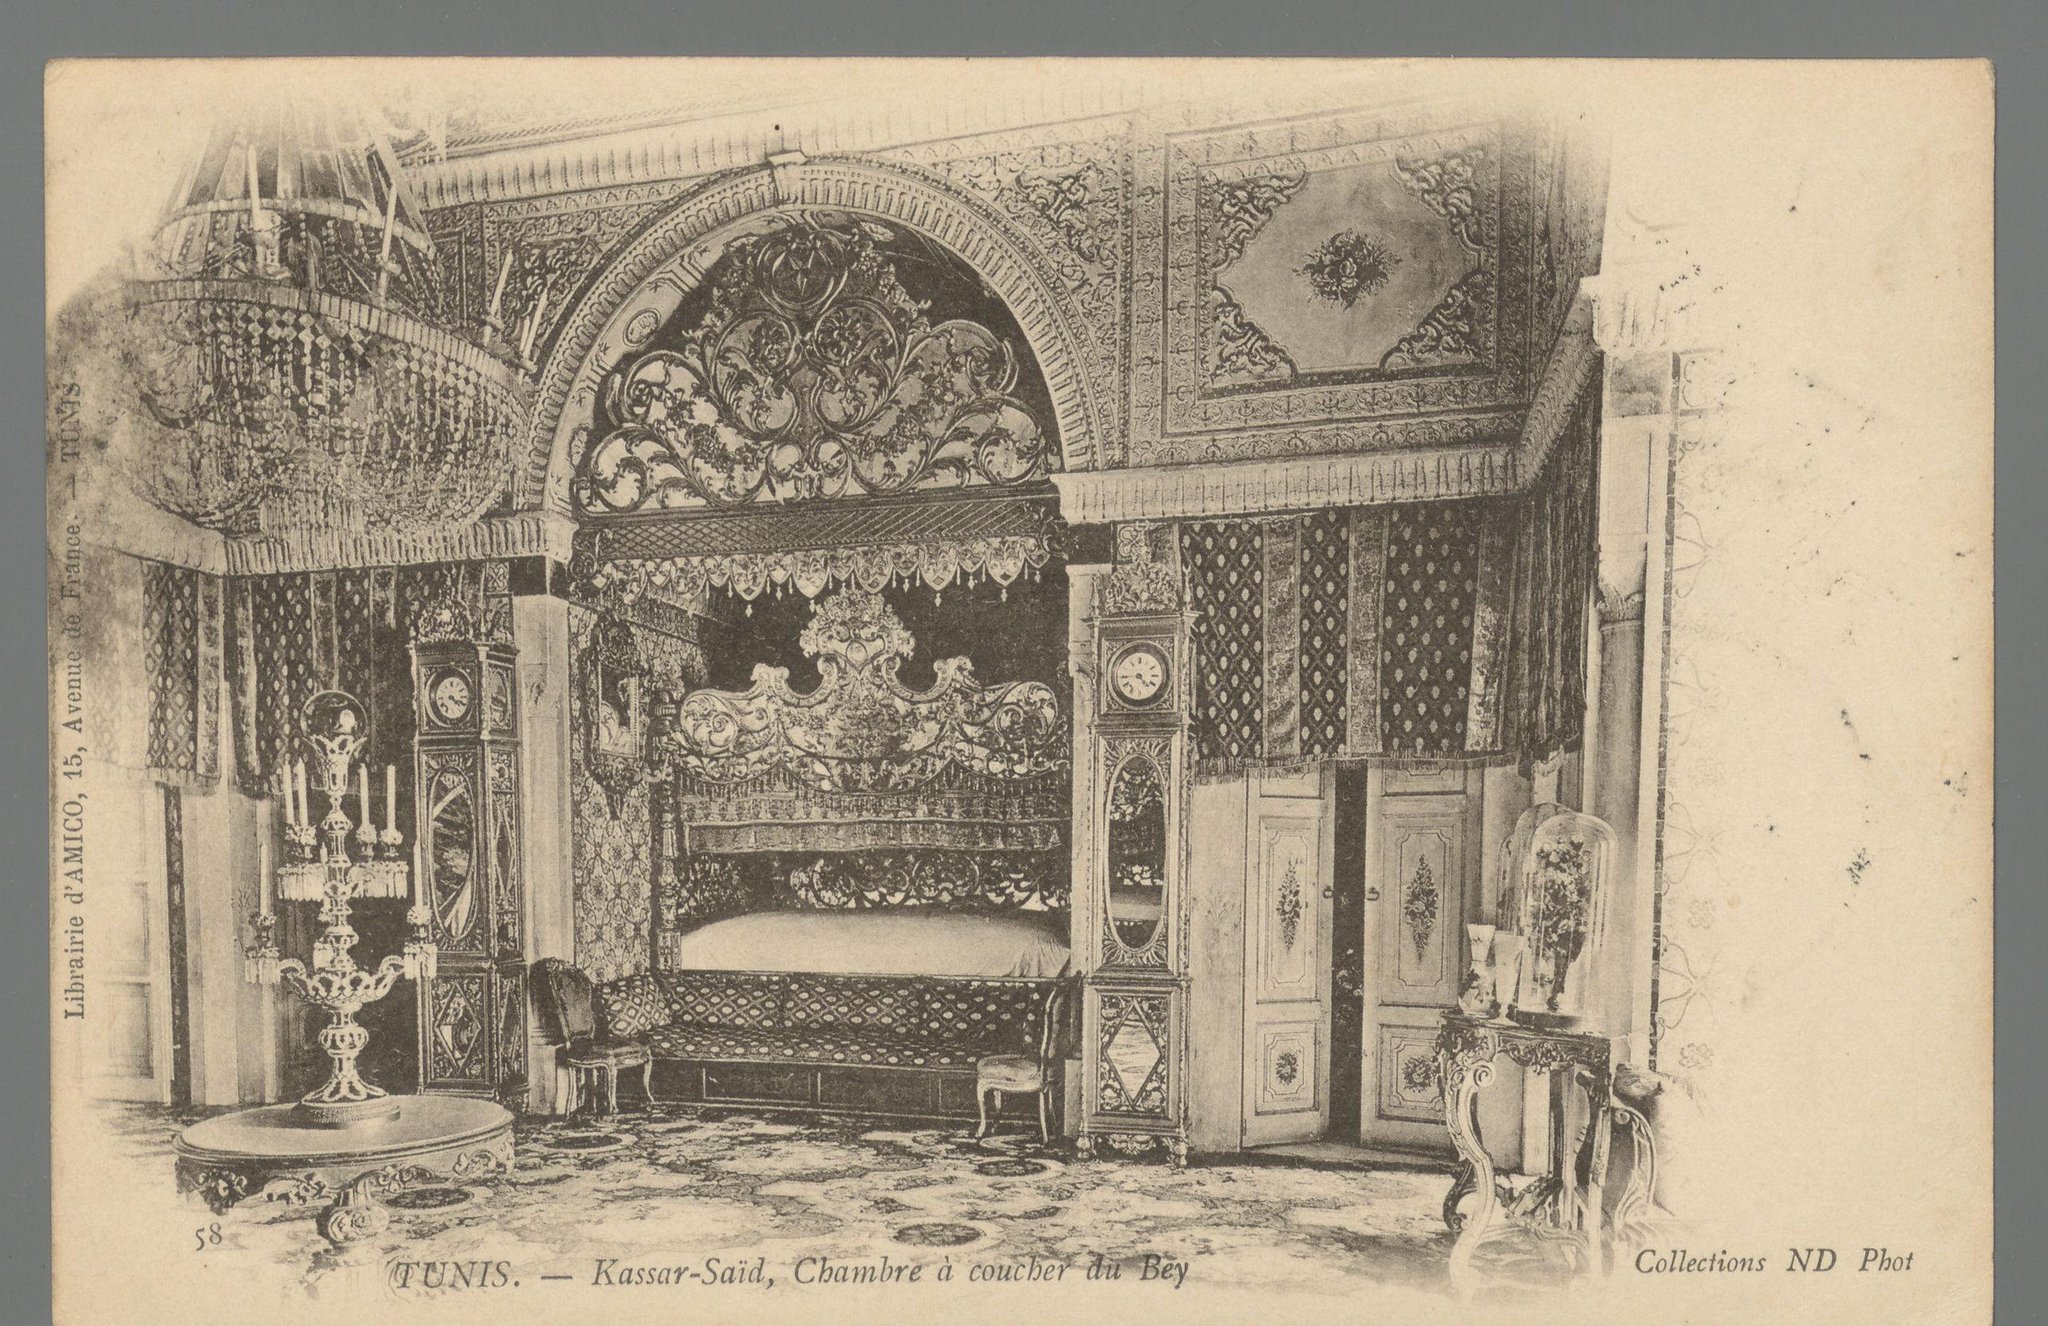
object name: photomechanical print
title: Tunis - Kassar-Saïd, Chambre à coucher du Bey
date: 1900-1903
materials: cardboard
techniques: photograph, writing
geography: tunis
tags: interior of the house, bed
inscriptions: poststempel, verso, gestempeld